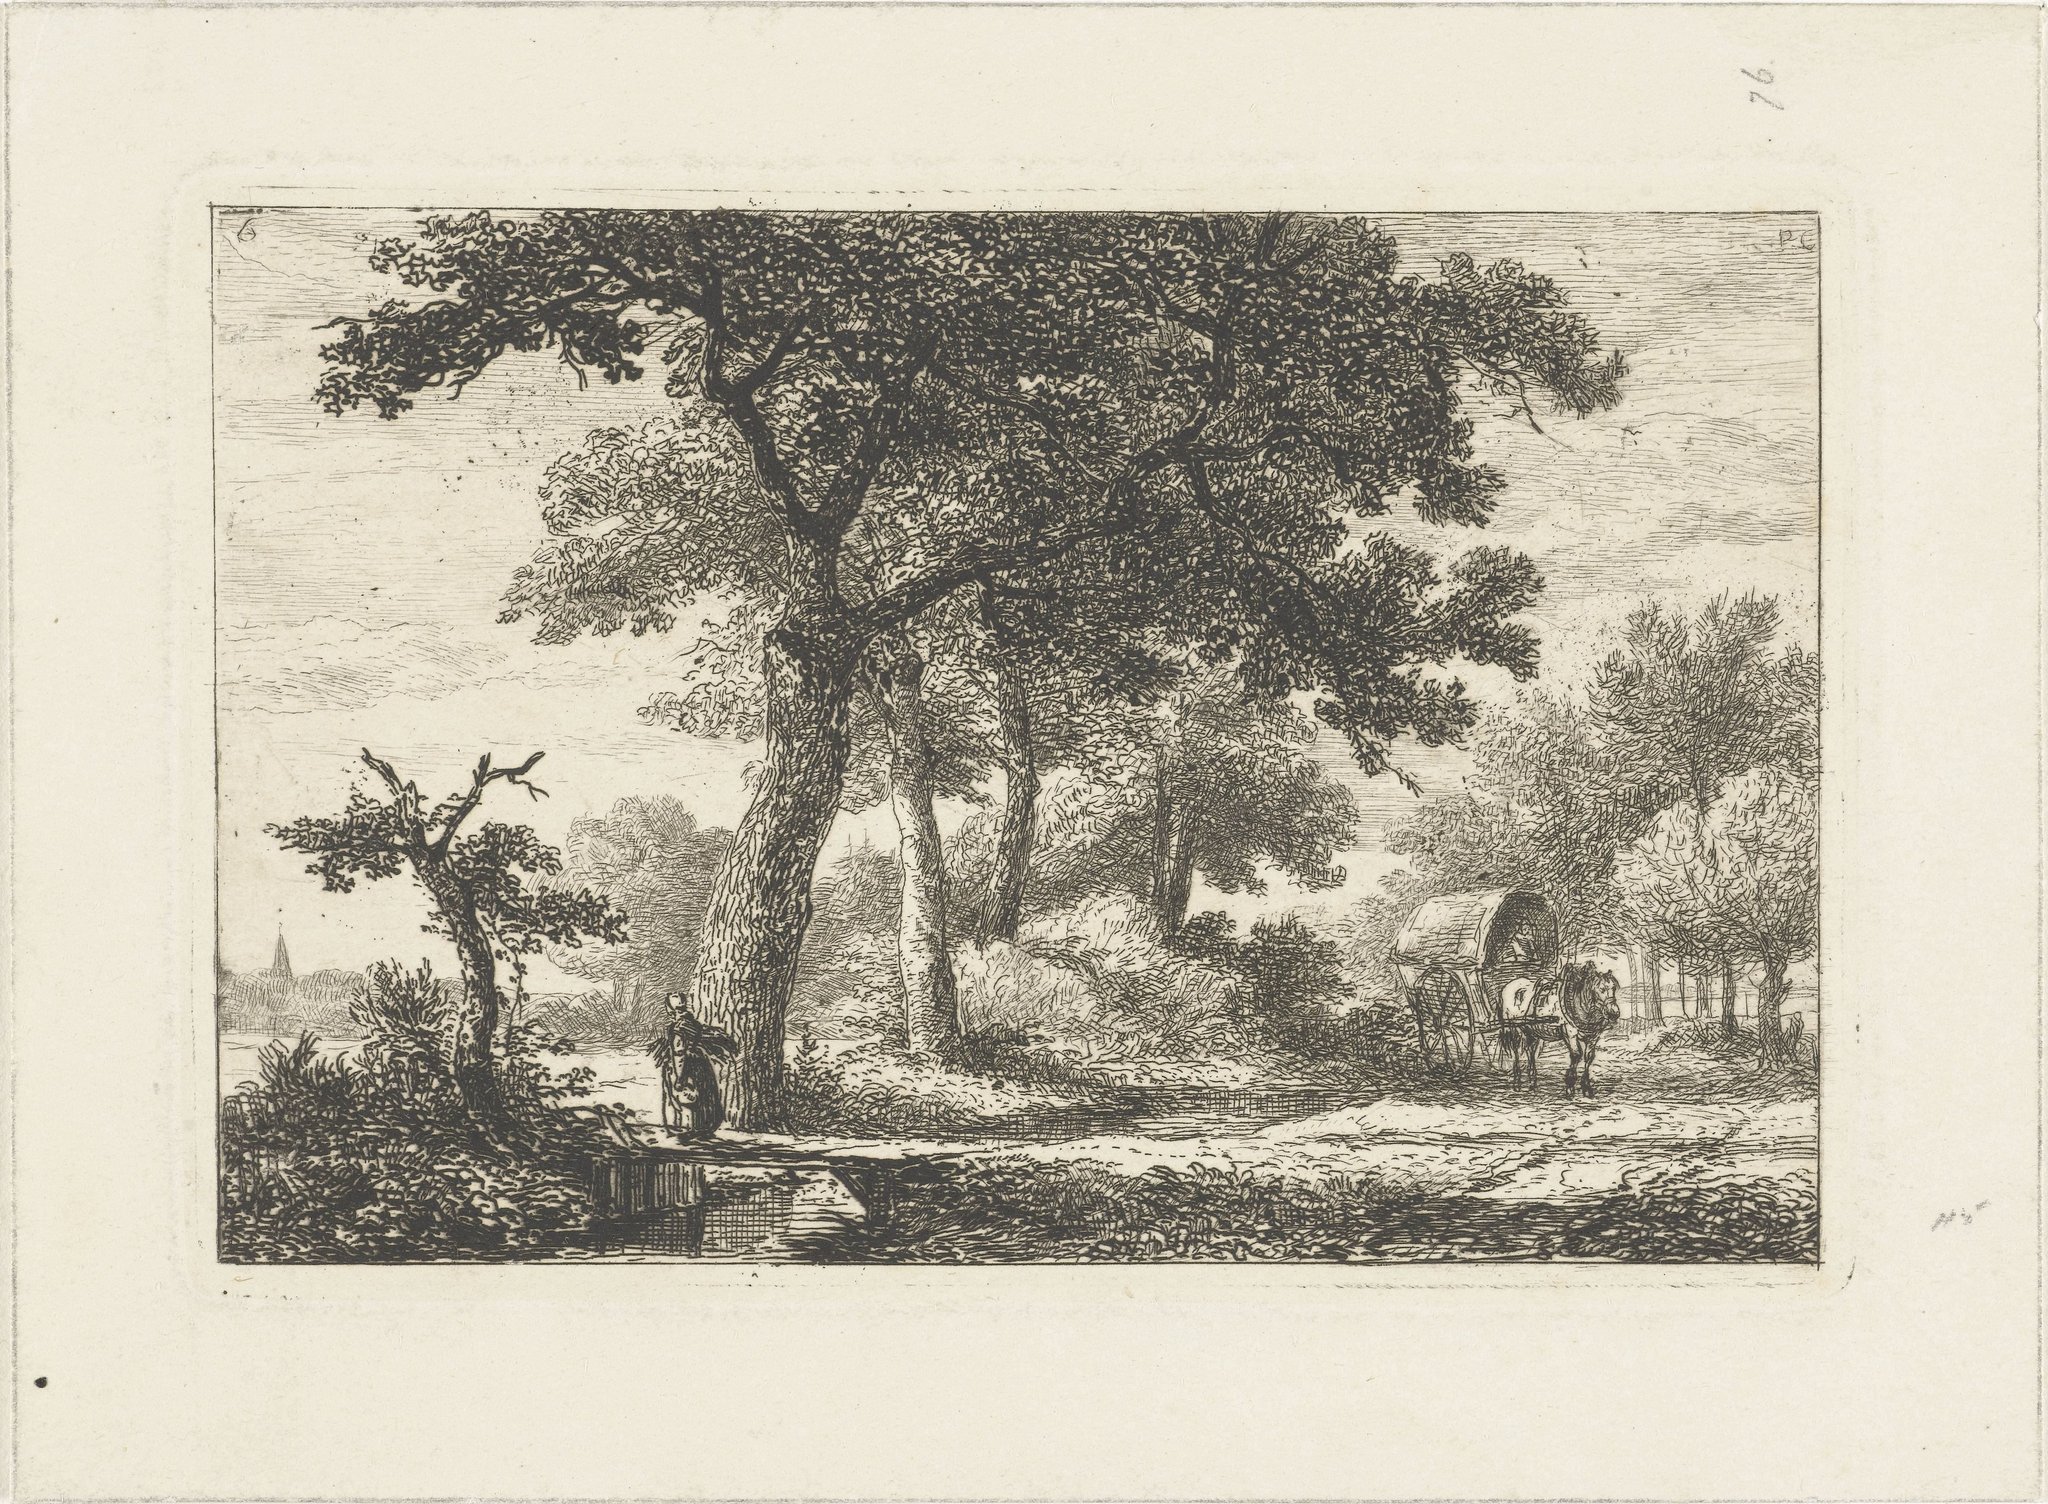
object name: print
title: Landschap met huifkar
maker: pieter casper christ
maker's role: draughtsman, print maker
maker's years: 1822-1888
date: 1860-1870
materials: paper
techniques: etching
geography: arnhem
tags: landscapes in the temperate zone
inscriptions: collector's mark: Lugt 2228